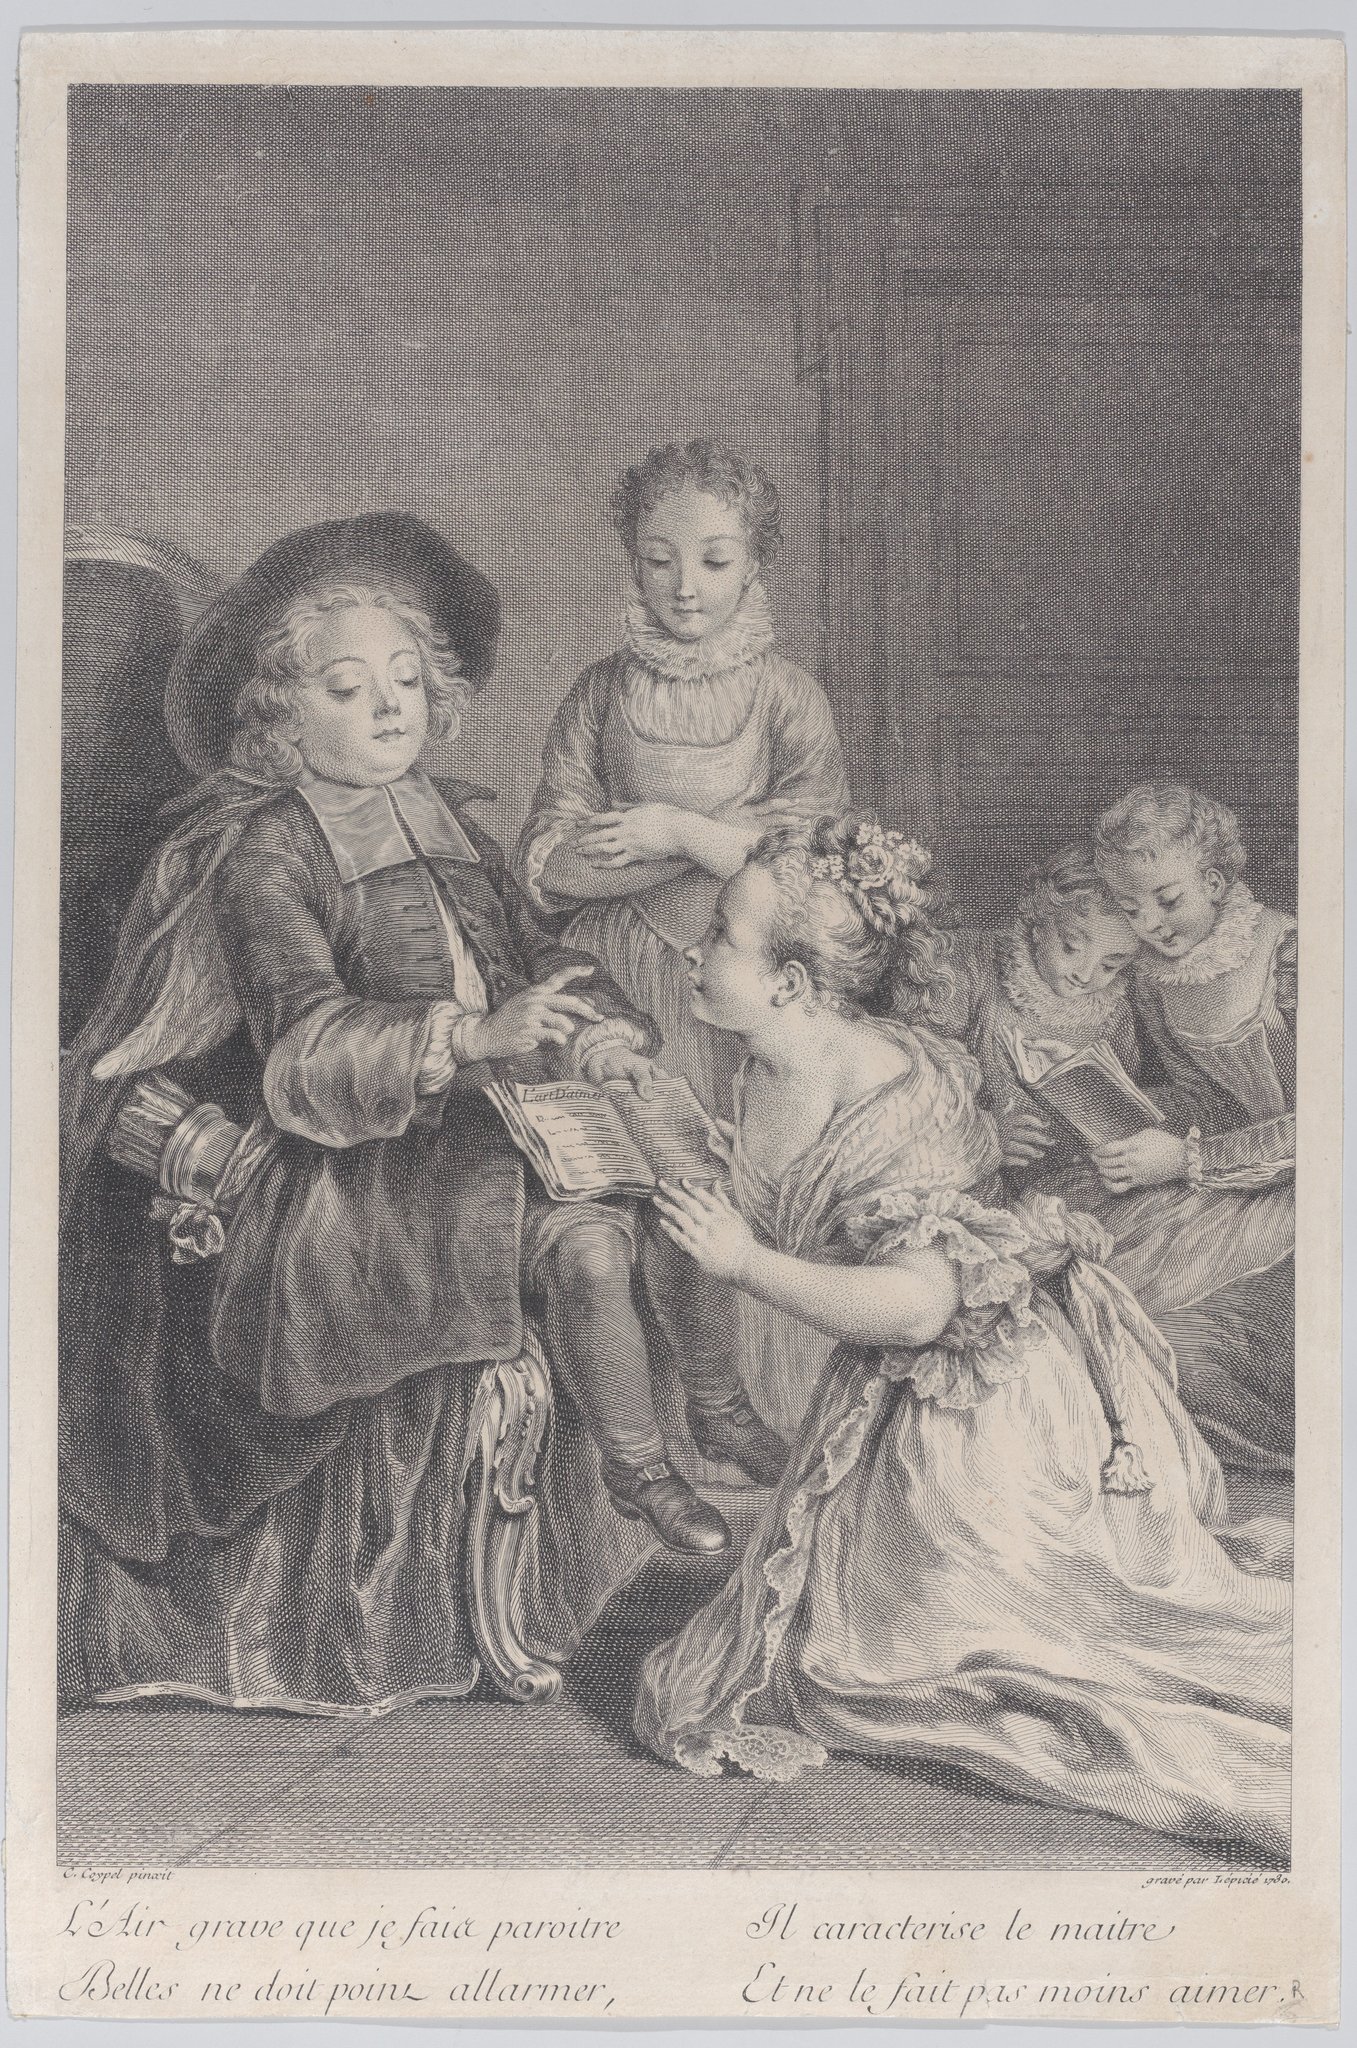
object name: print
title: Cupid teaching (L'Amour-Précepteur)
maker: bernard lepicié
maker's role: artist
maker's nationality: french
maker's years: 1698-1755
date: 1730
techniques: engraving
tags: girls,reading,cupid